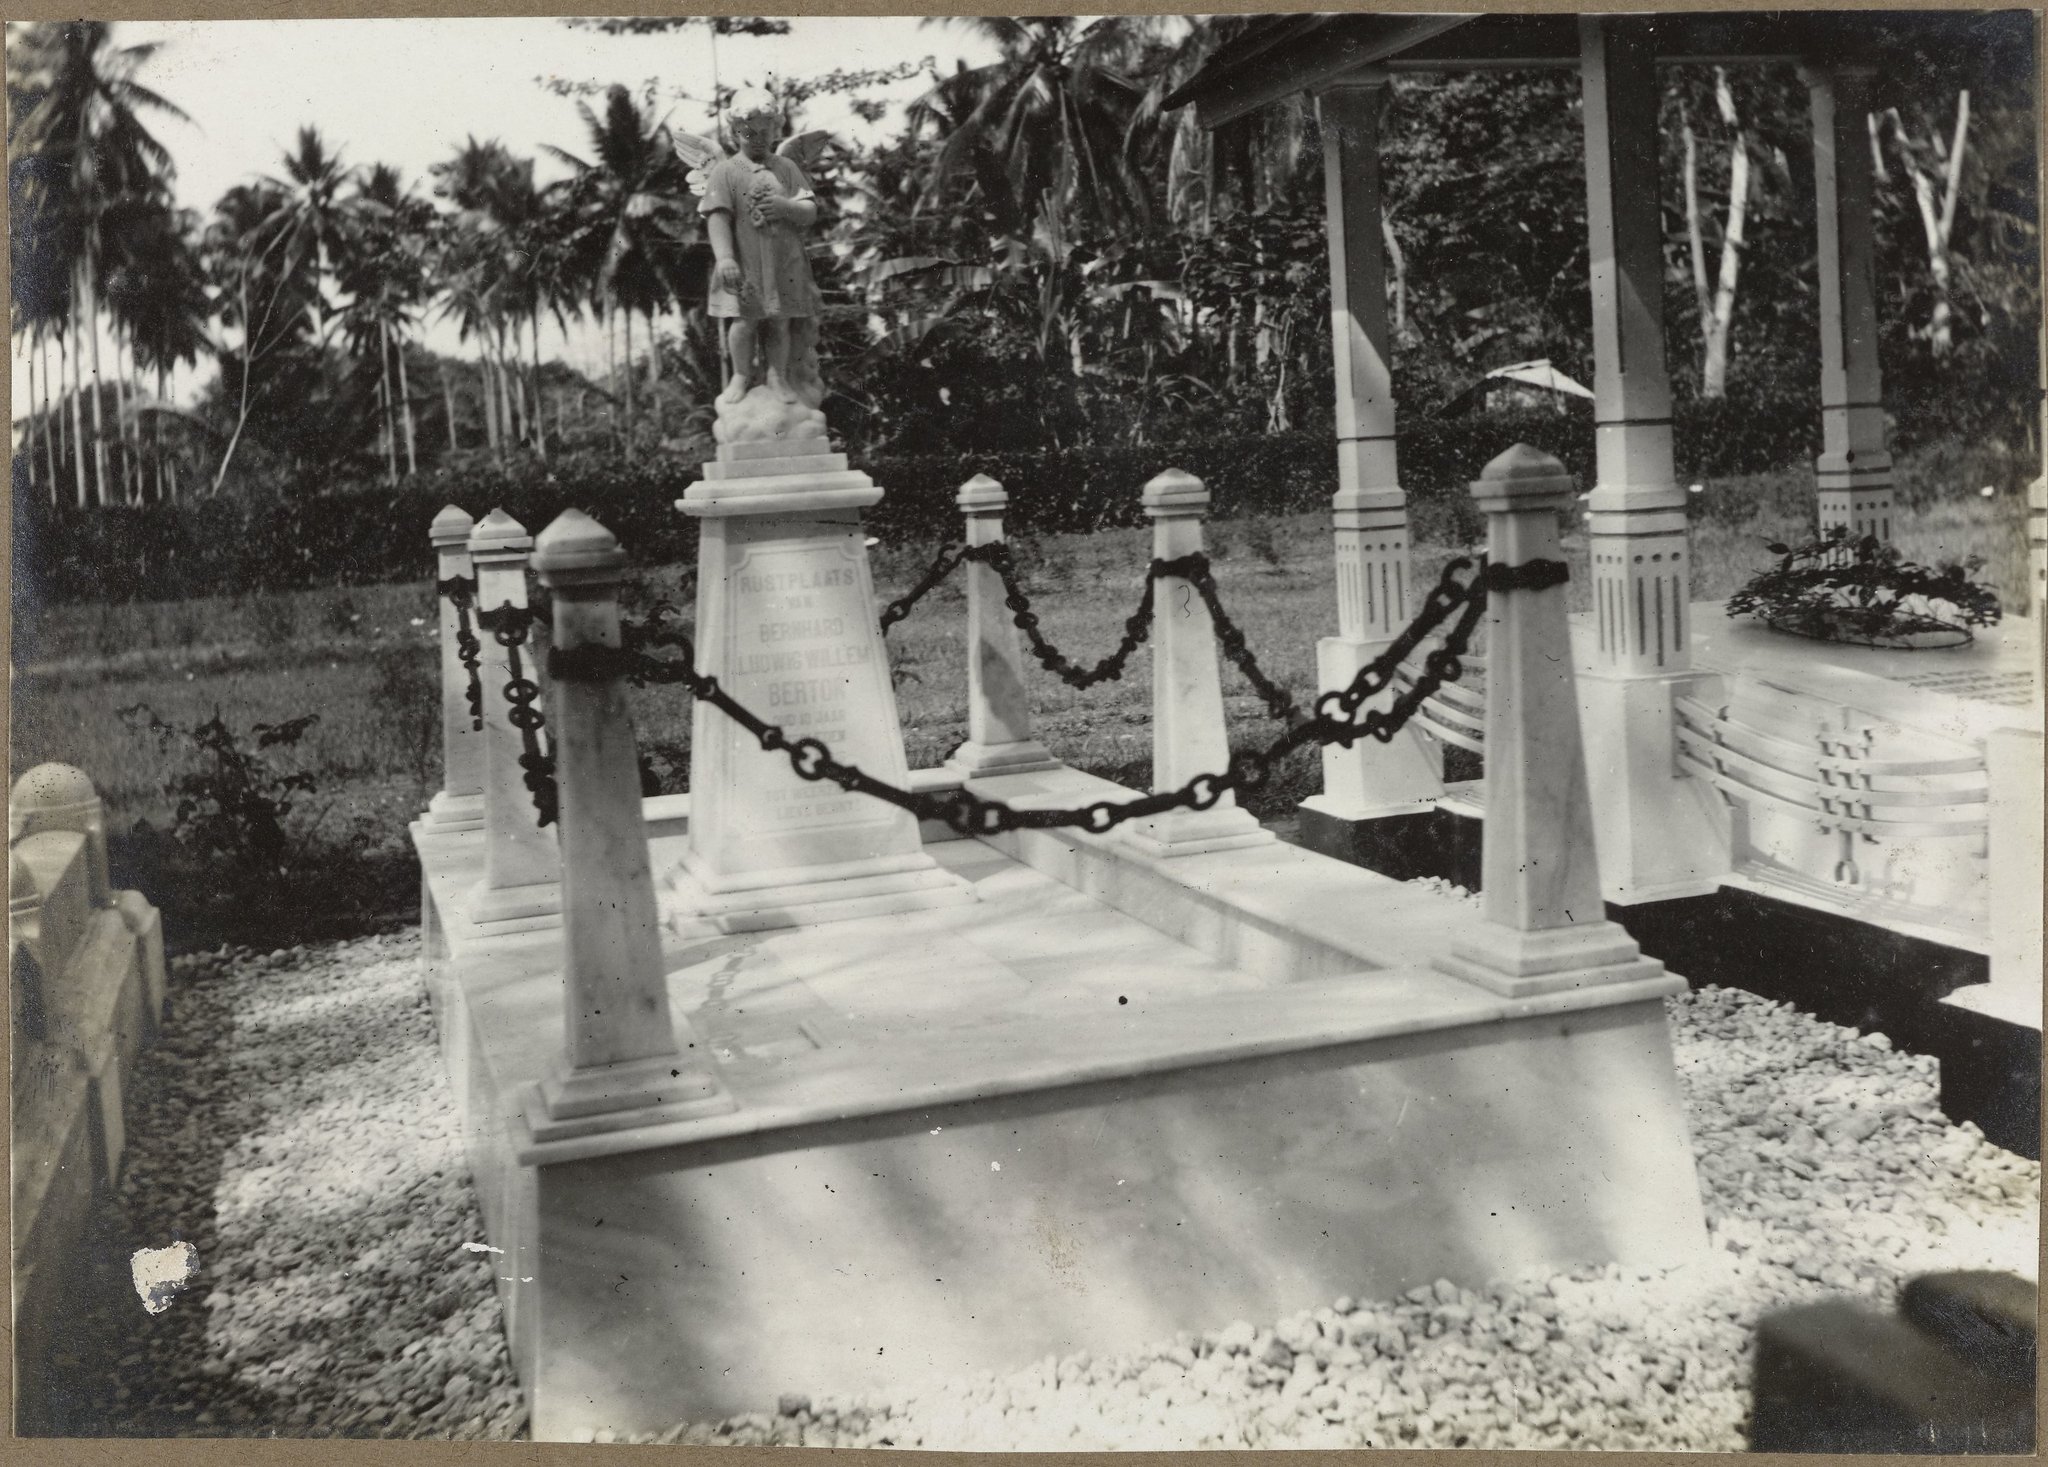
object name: photograph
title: Begraafplaats met graf van B.L.W. Bertok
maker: Anonymous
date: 1917-1919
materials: photographic support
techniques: gelatin silver print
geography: medan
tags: grave, tomb, churchyard, cemetery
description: Een begraafplaats te Medan met het graf van Bernhard Ludwig Willem Bertok (of Berton). Foto in het fotoalbum van het Nederlandse architectenbureau en aannemersbedrijf Bennink en Riphagen te Medan in de jaren ca. 1914-1919.